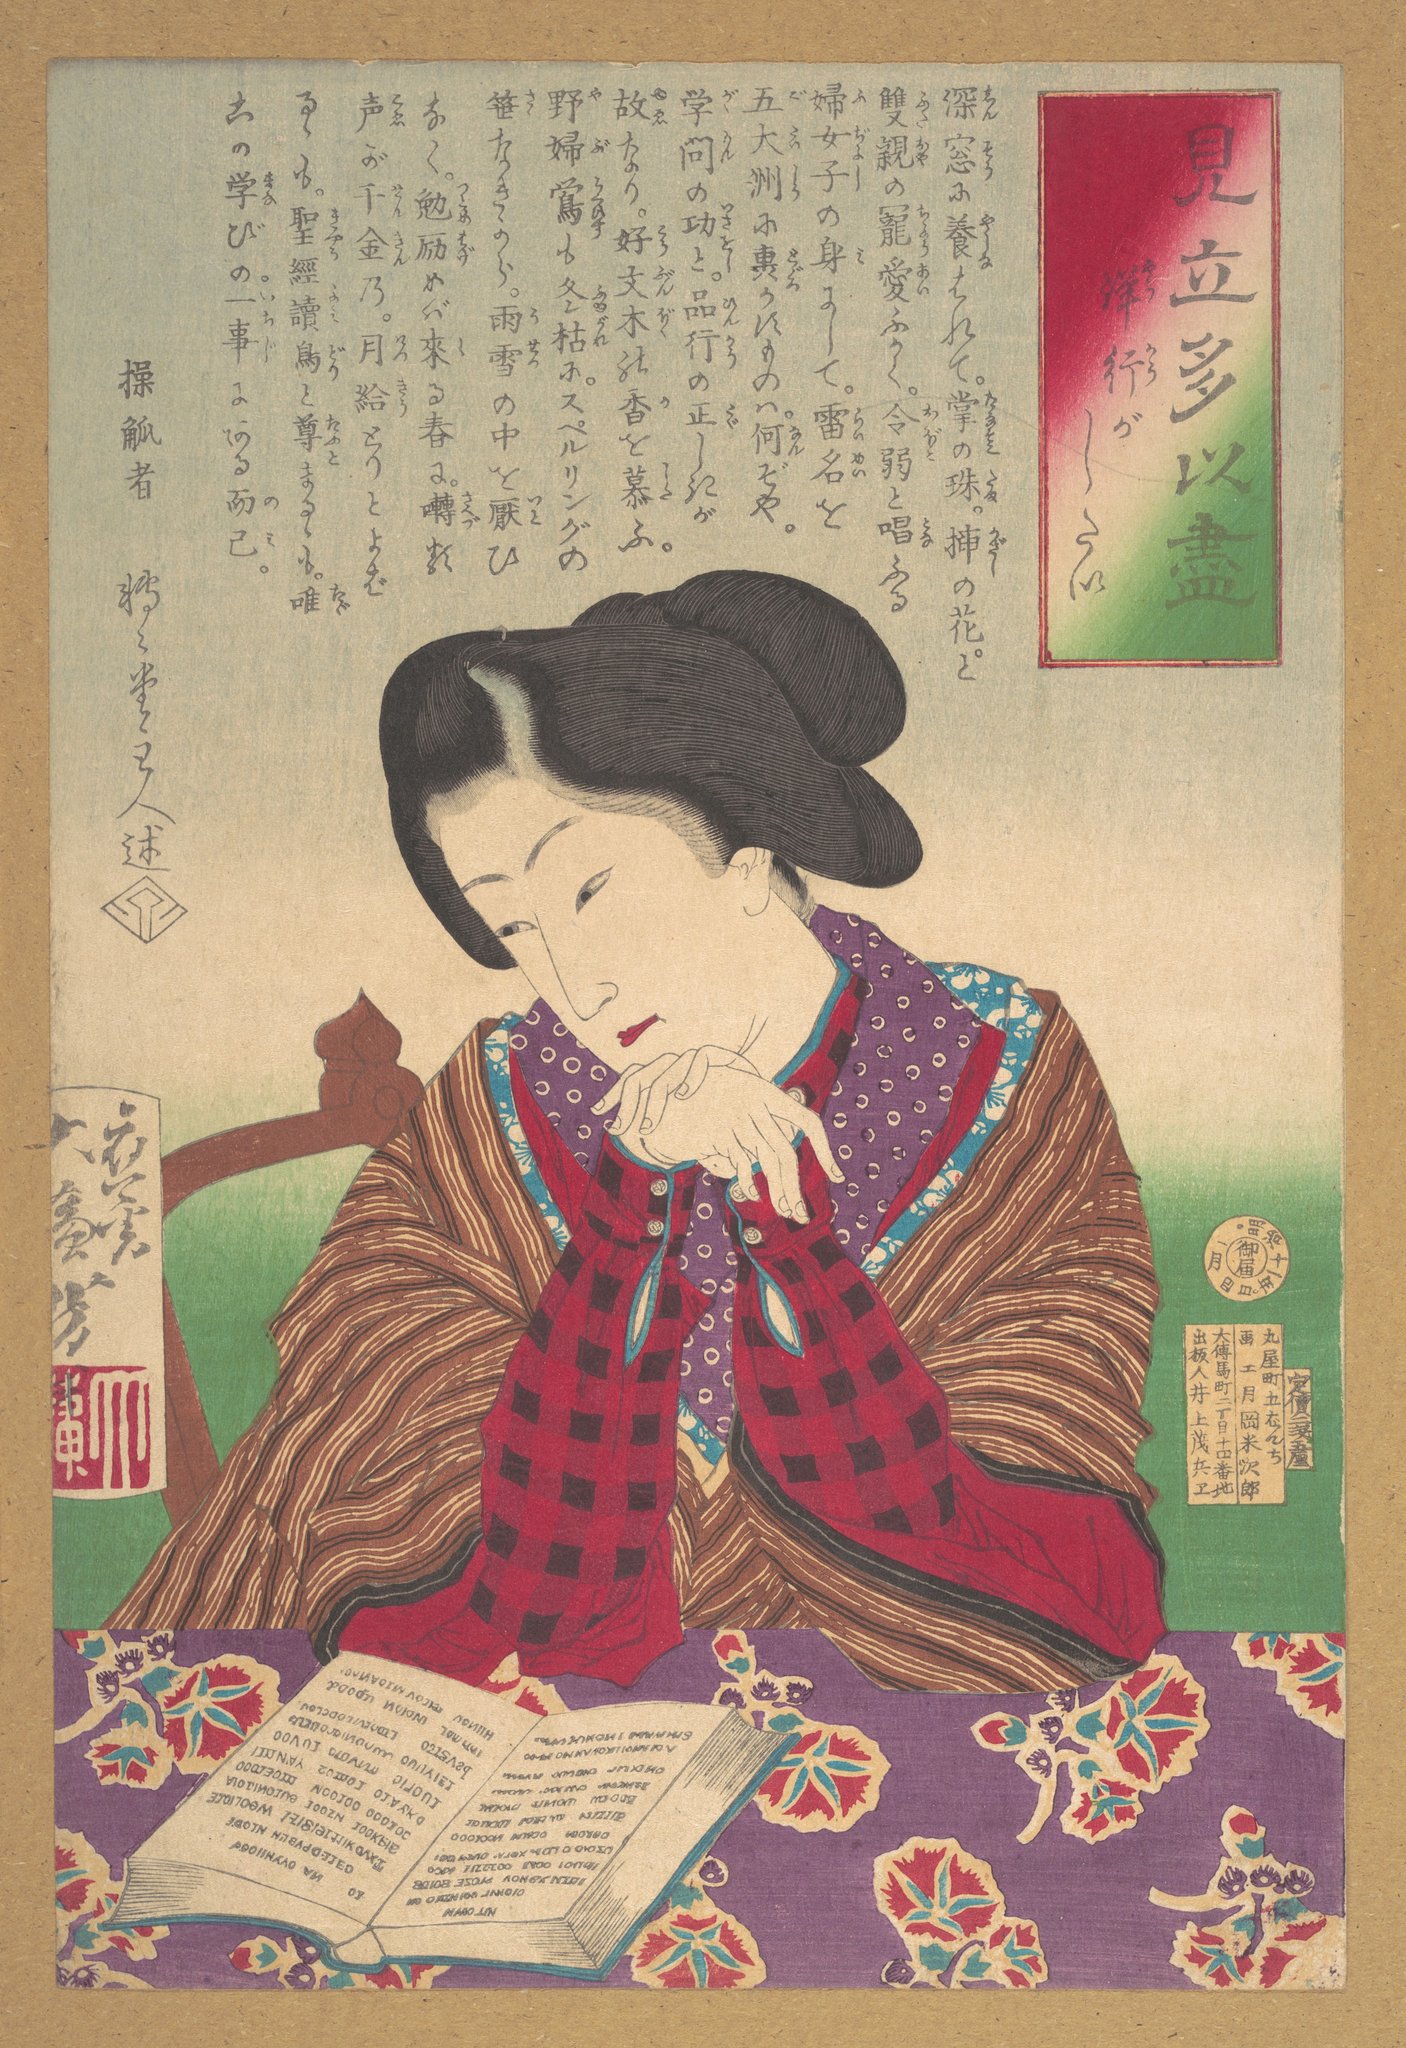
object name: print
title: Collection of Desires, Wish for Foreign Travel (Mitate Tai zukushi-yōkō ga shitai)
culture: japanese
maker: tsukioka yoshitoshi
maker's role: artist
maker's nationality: japanese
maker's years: 1839-1892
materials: ink, paper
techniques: woodblock print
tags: books,women,reading